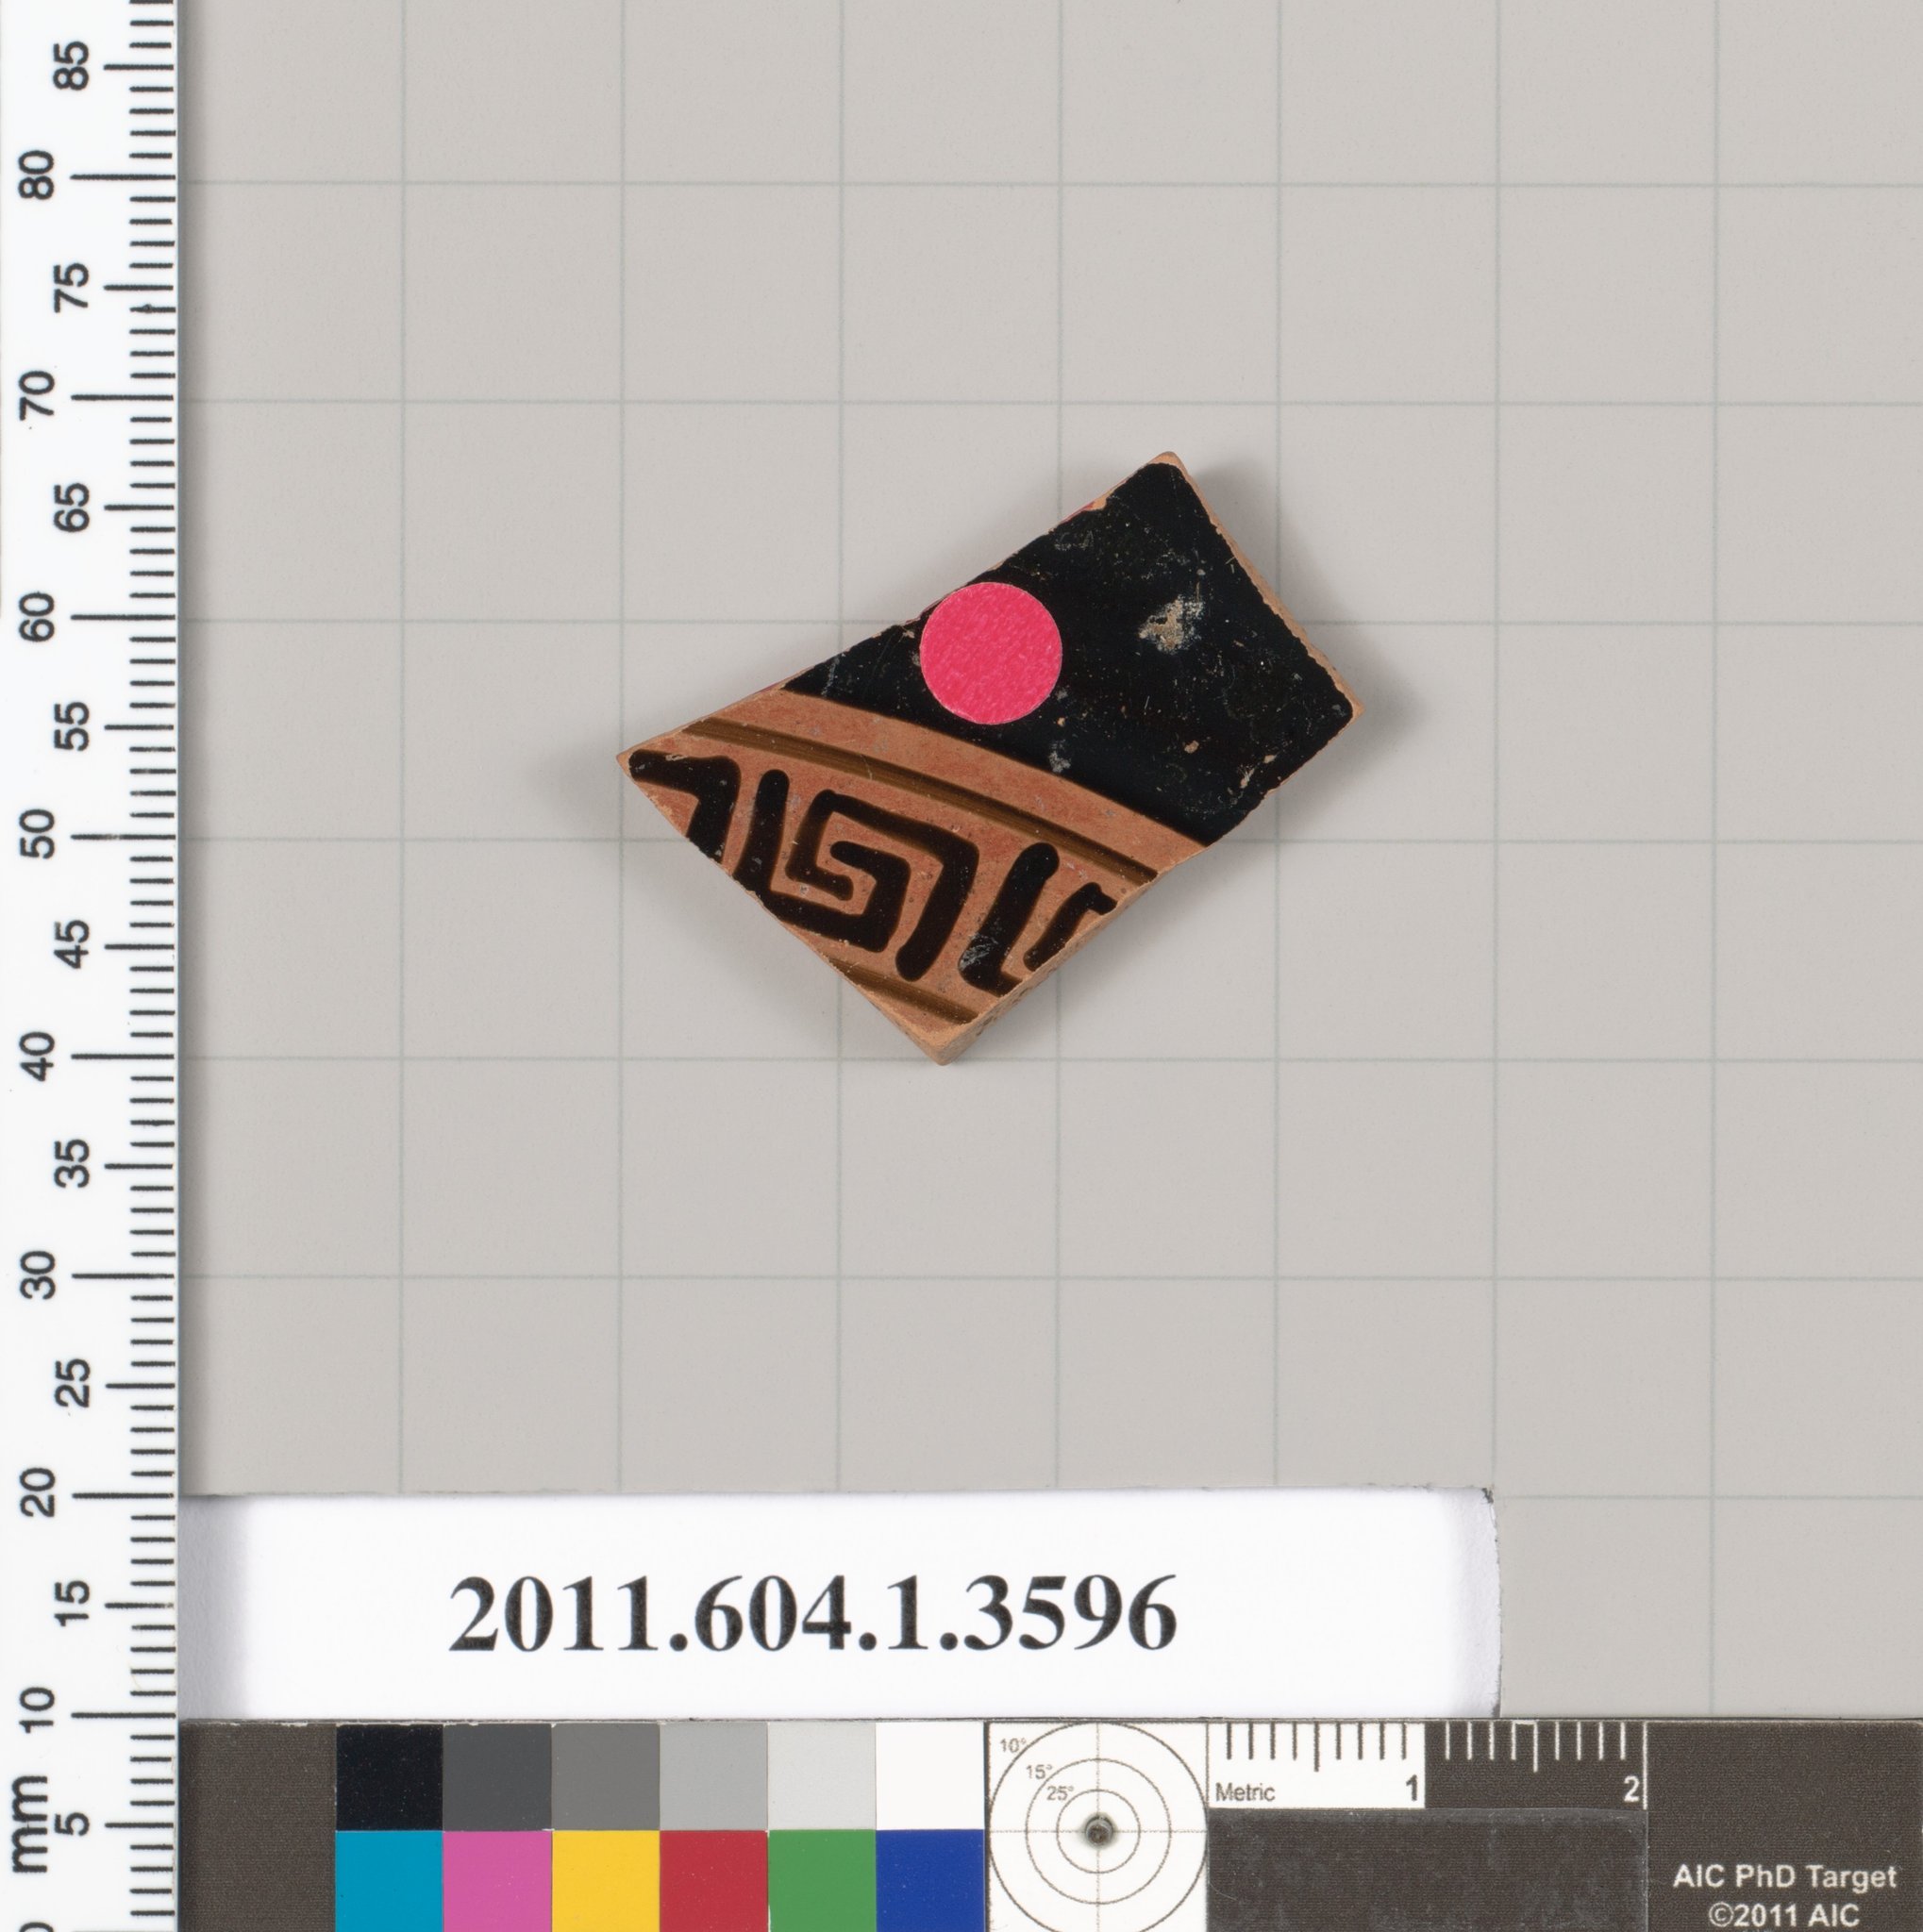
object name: kylix fragment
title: Terracotta fragment of a kylix (drinking cup)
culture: greek, attic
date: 490-480 BCE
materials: terracotta